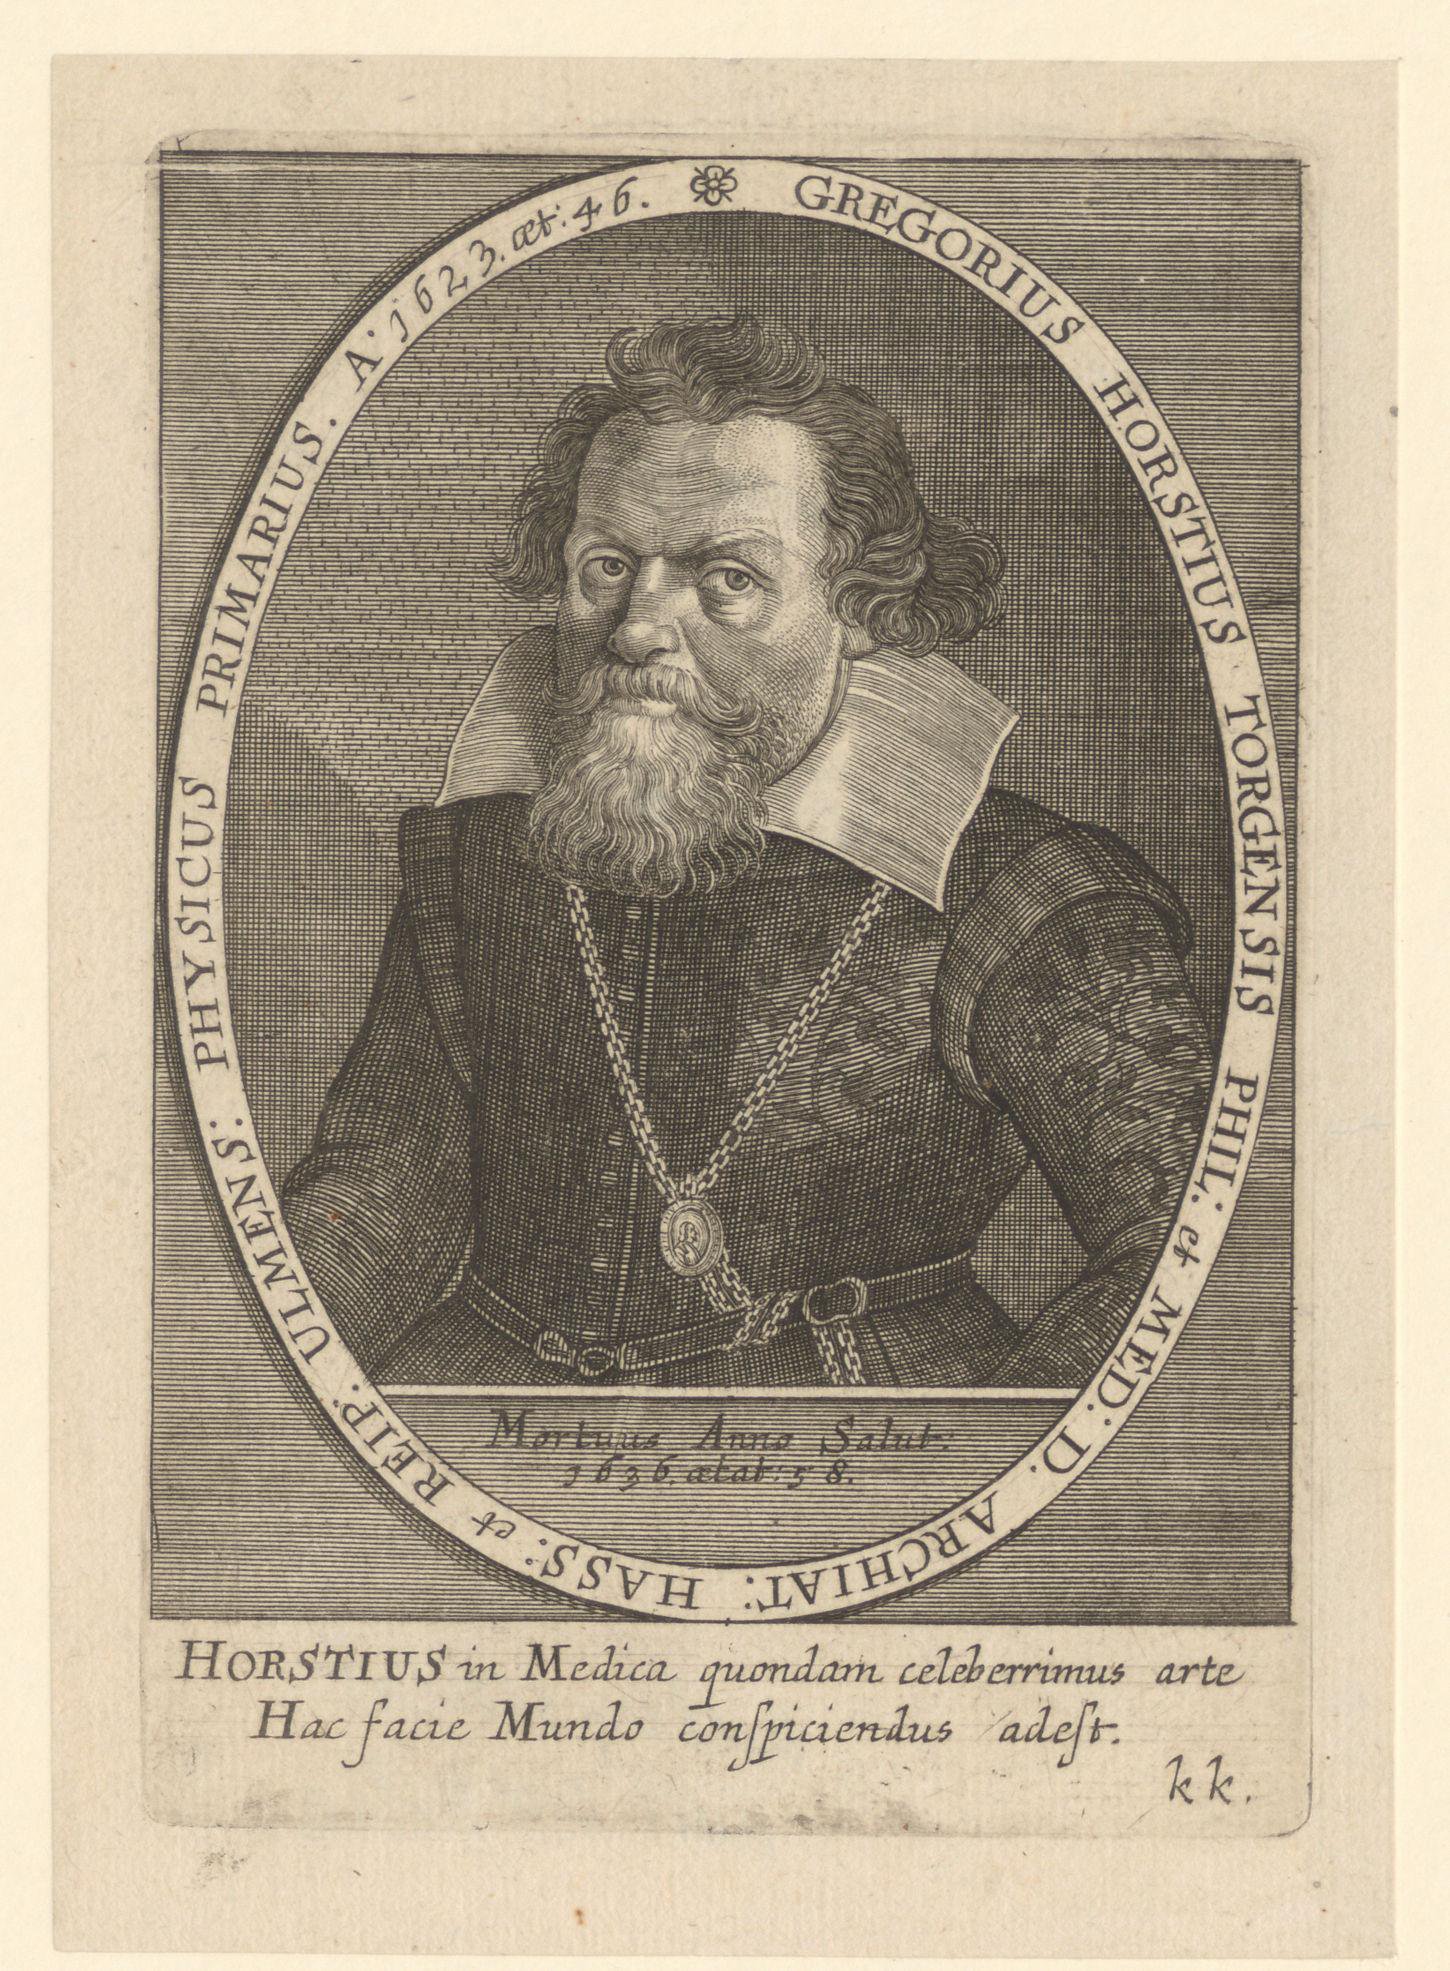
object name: print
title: Portret van Gregor Horst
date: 1623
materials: paper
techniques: engraving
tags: further education (+ portrait of teacher, professor), historical persons, physician, doctor (+ portrait of scholar, scientist)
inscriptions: collector's mark: Lugt 2233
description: Tekst in het Latijn in de omlijsting en in de ondermarge.